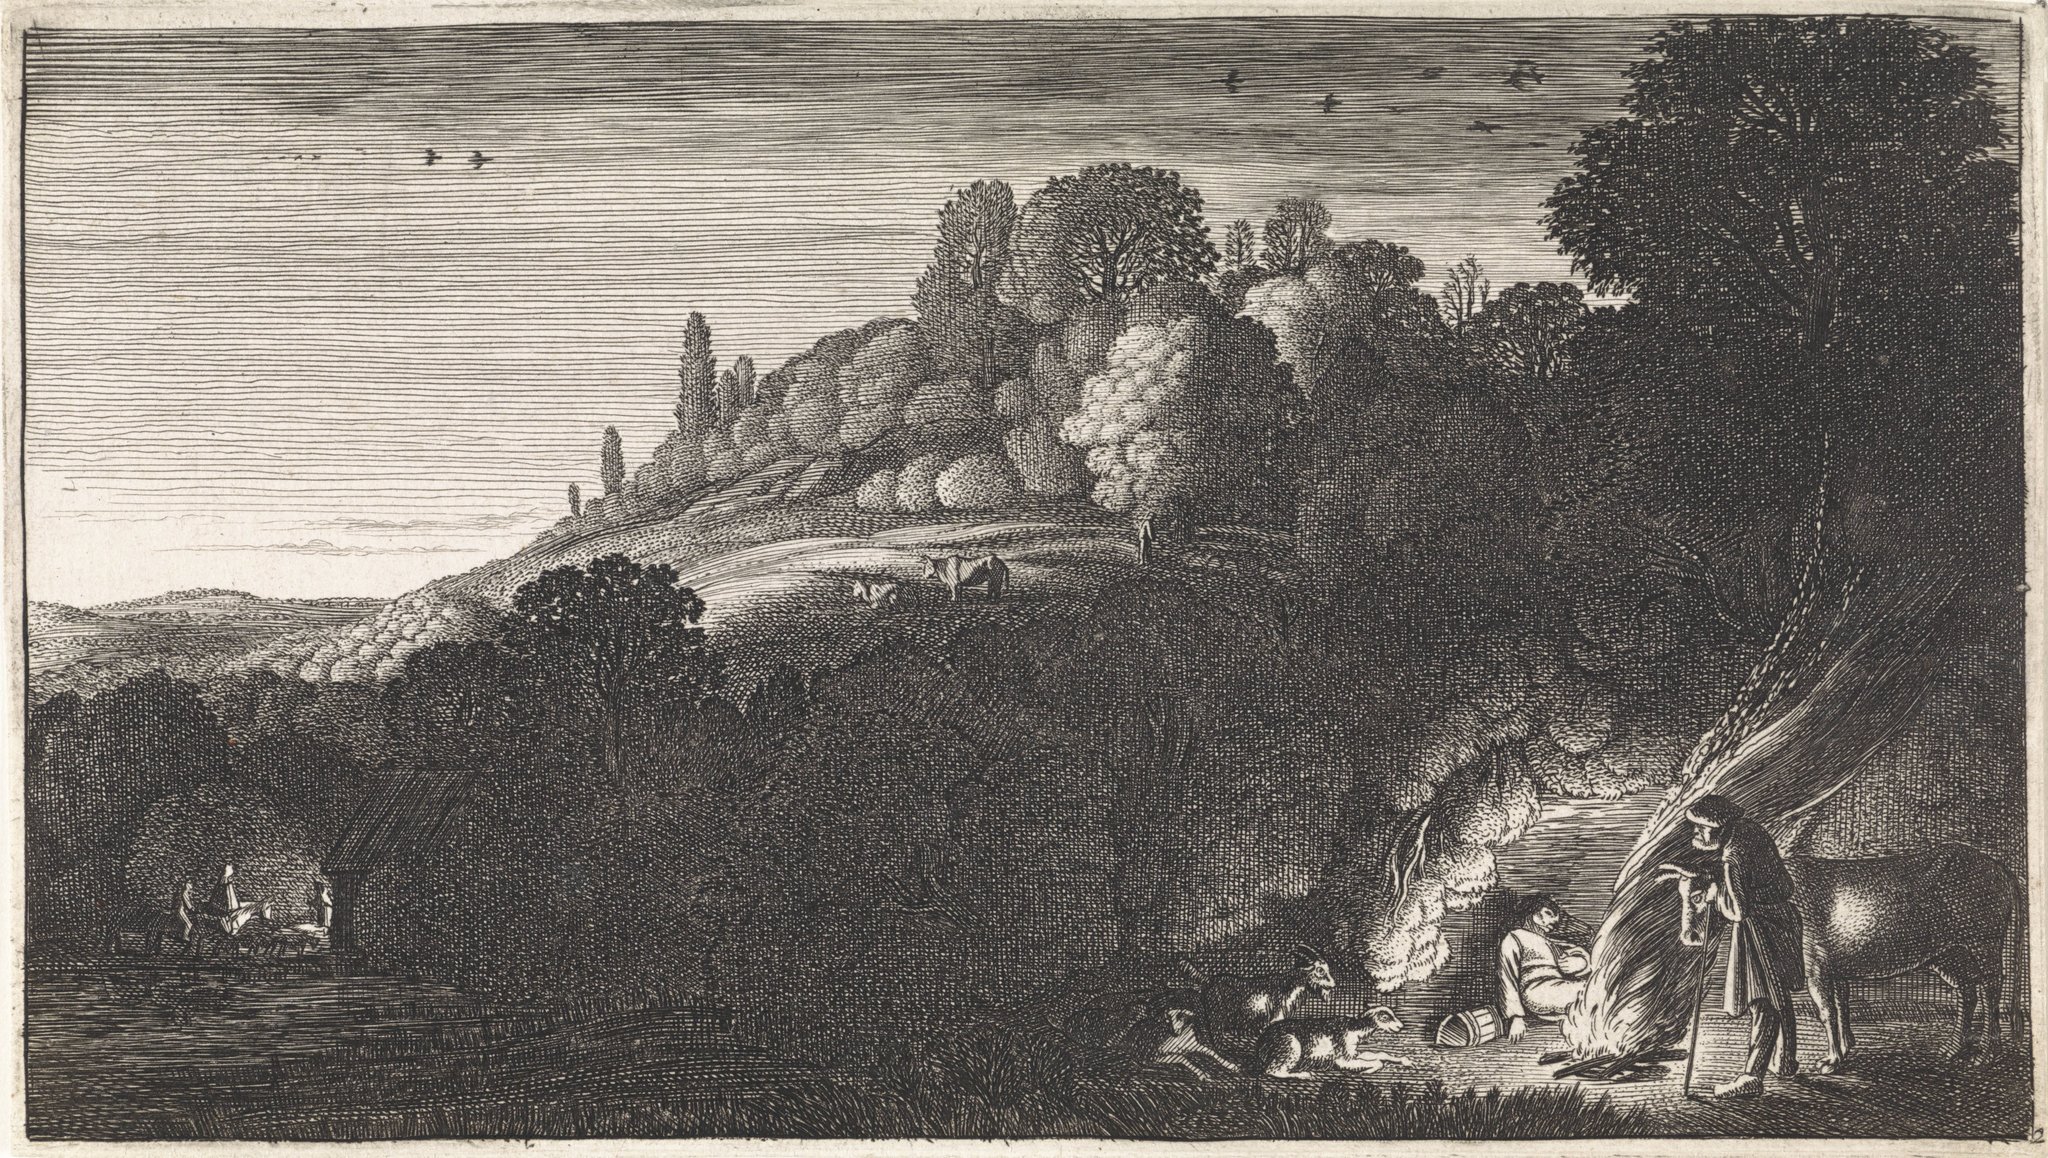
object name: print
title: Dageraad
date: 1603-1652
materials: paper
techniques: engraving, etching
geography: northern netherlands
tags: dawn, camp-fire; watch-fire, morning ~ landscape (sometimes titled 'aurora')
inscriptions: collector's mark: Lugt 2228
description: Heuvellandschap met rechts op de voorgrond herders bij een kampvuur. Op de achtergrond het ochtendgloren. Prent uit een serie van vier.